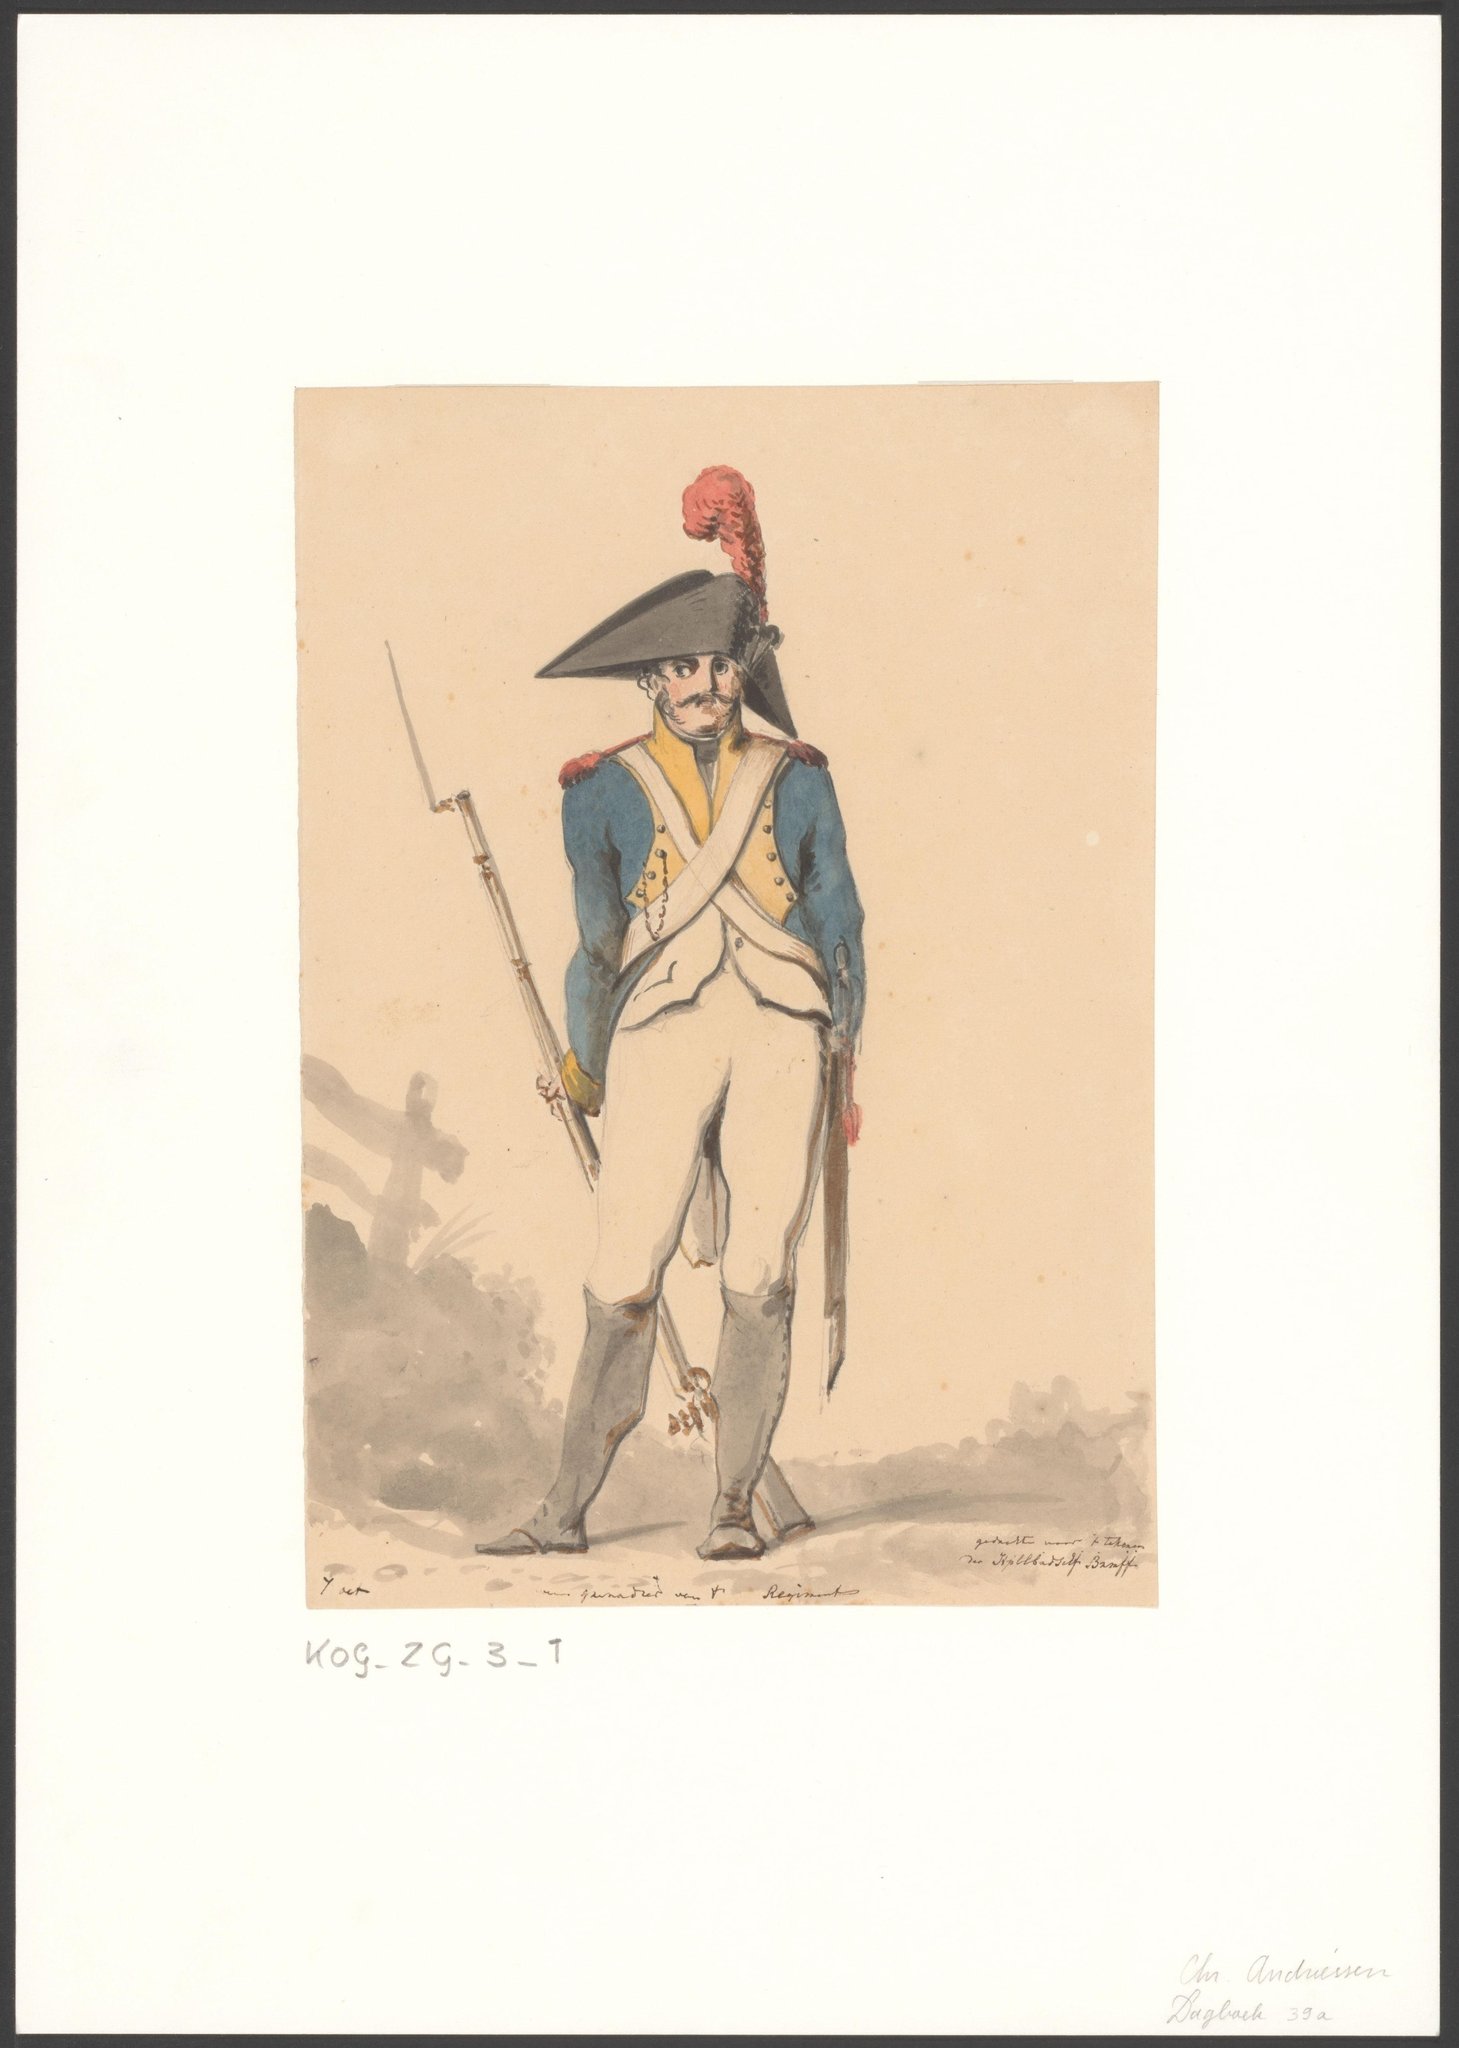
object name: drawing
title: Staande garnadier van het regiment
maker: christiaan andriessen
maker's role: draughtsman, print maker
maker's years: 1775-1846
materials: ink, paper, pencil, watercolor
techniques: brush, pen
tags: (military) uniforms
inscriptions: inscription: ‘een garnadier van 't Regiment’, inscription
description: Dagboekblad uit het getekende dagboek dat Christiaan Andriessen bijhield van 1805 tot en met 1808.